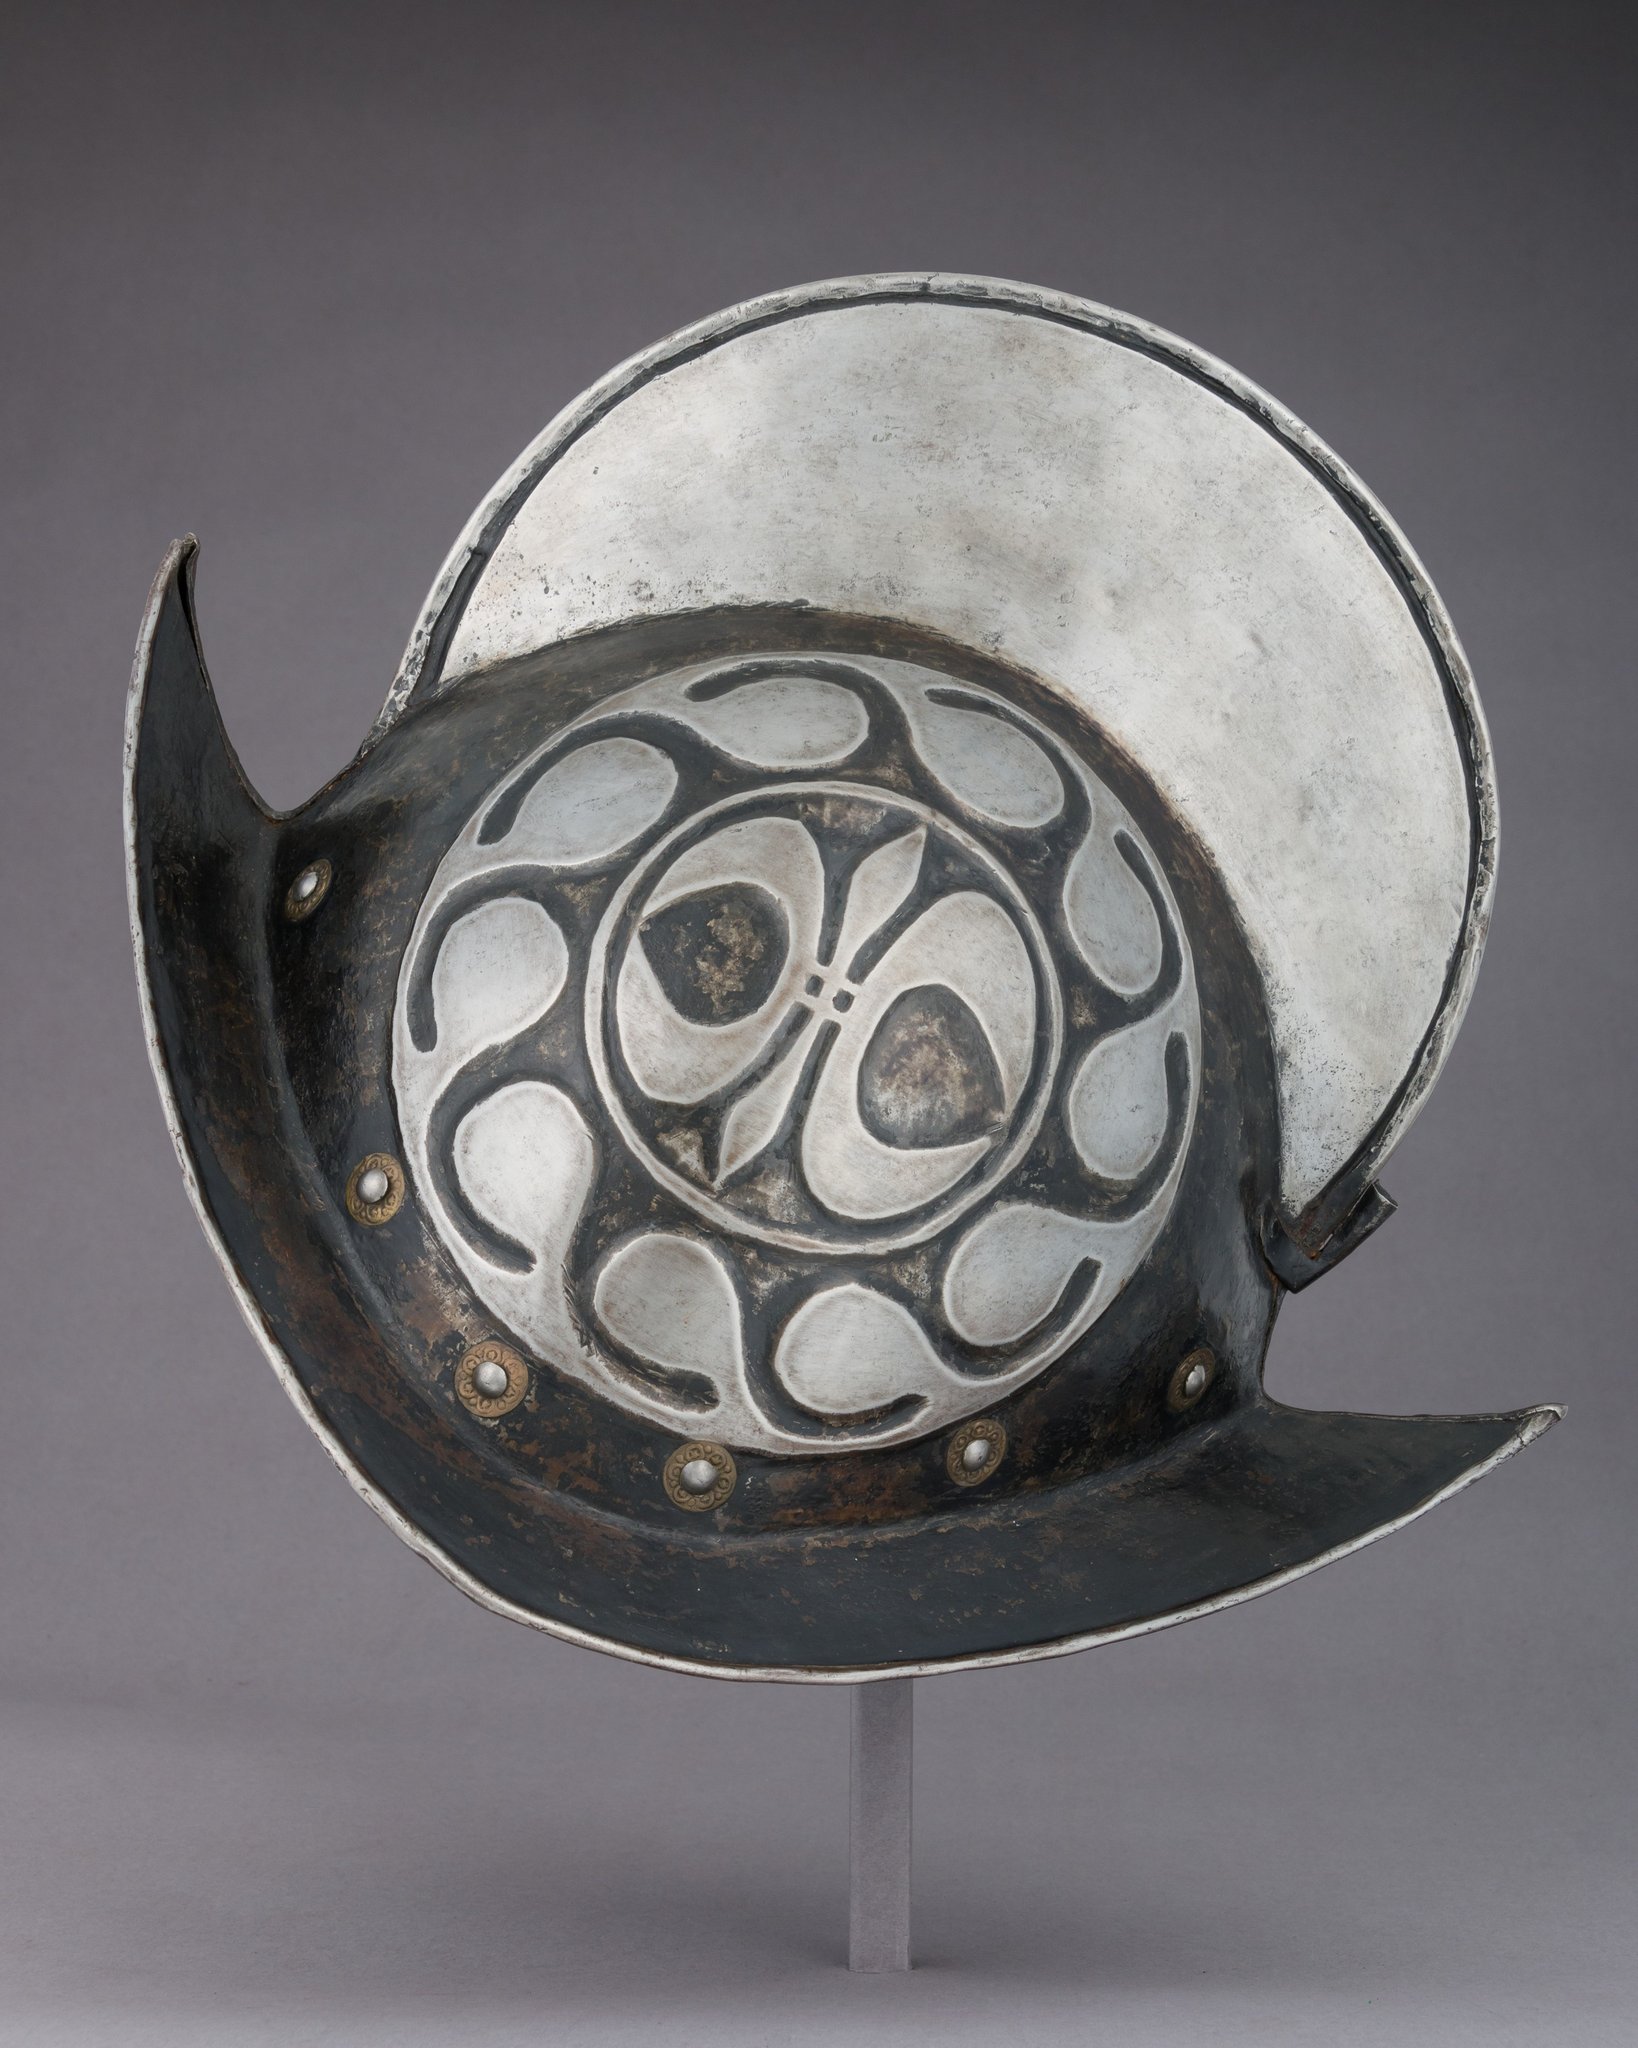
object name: morion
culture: german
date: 1600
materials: brass, leather, steel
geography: germany